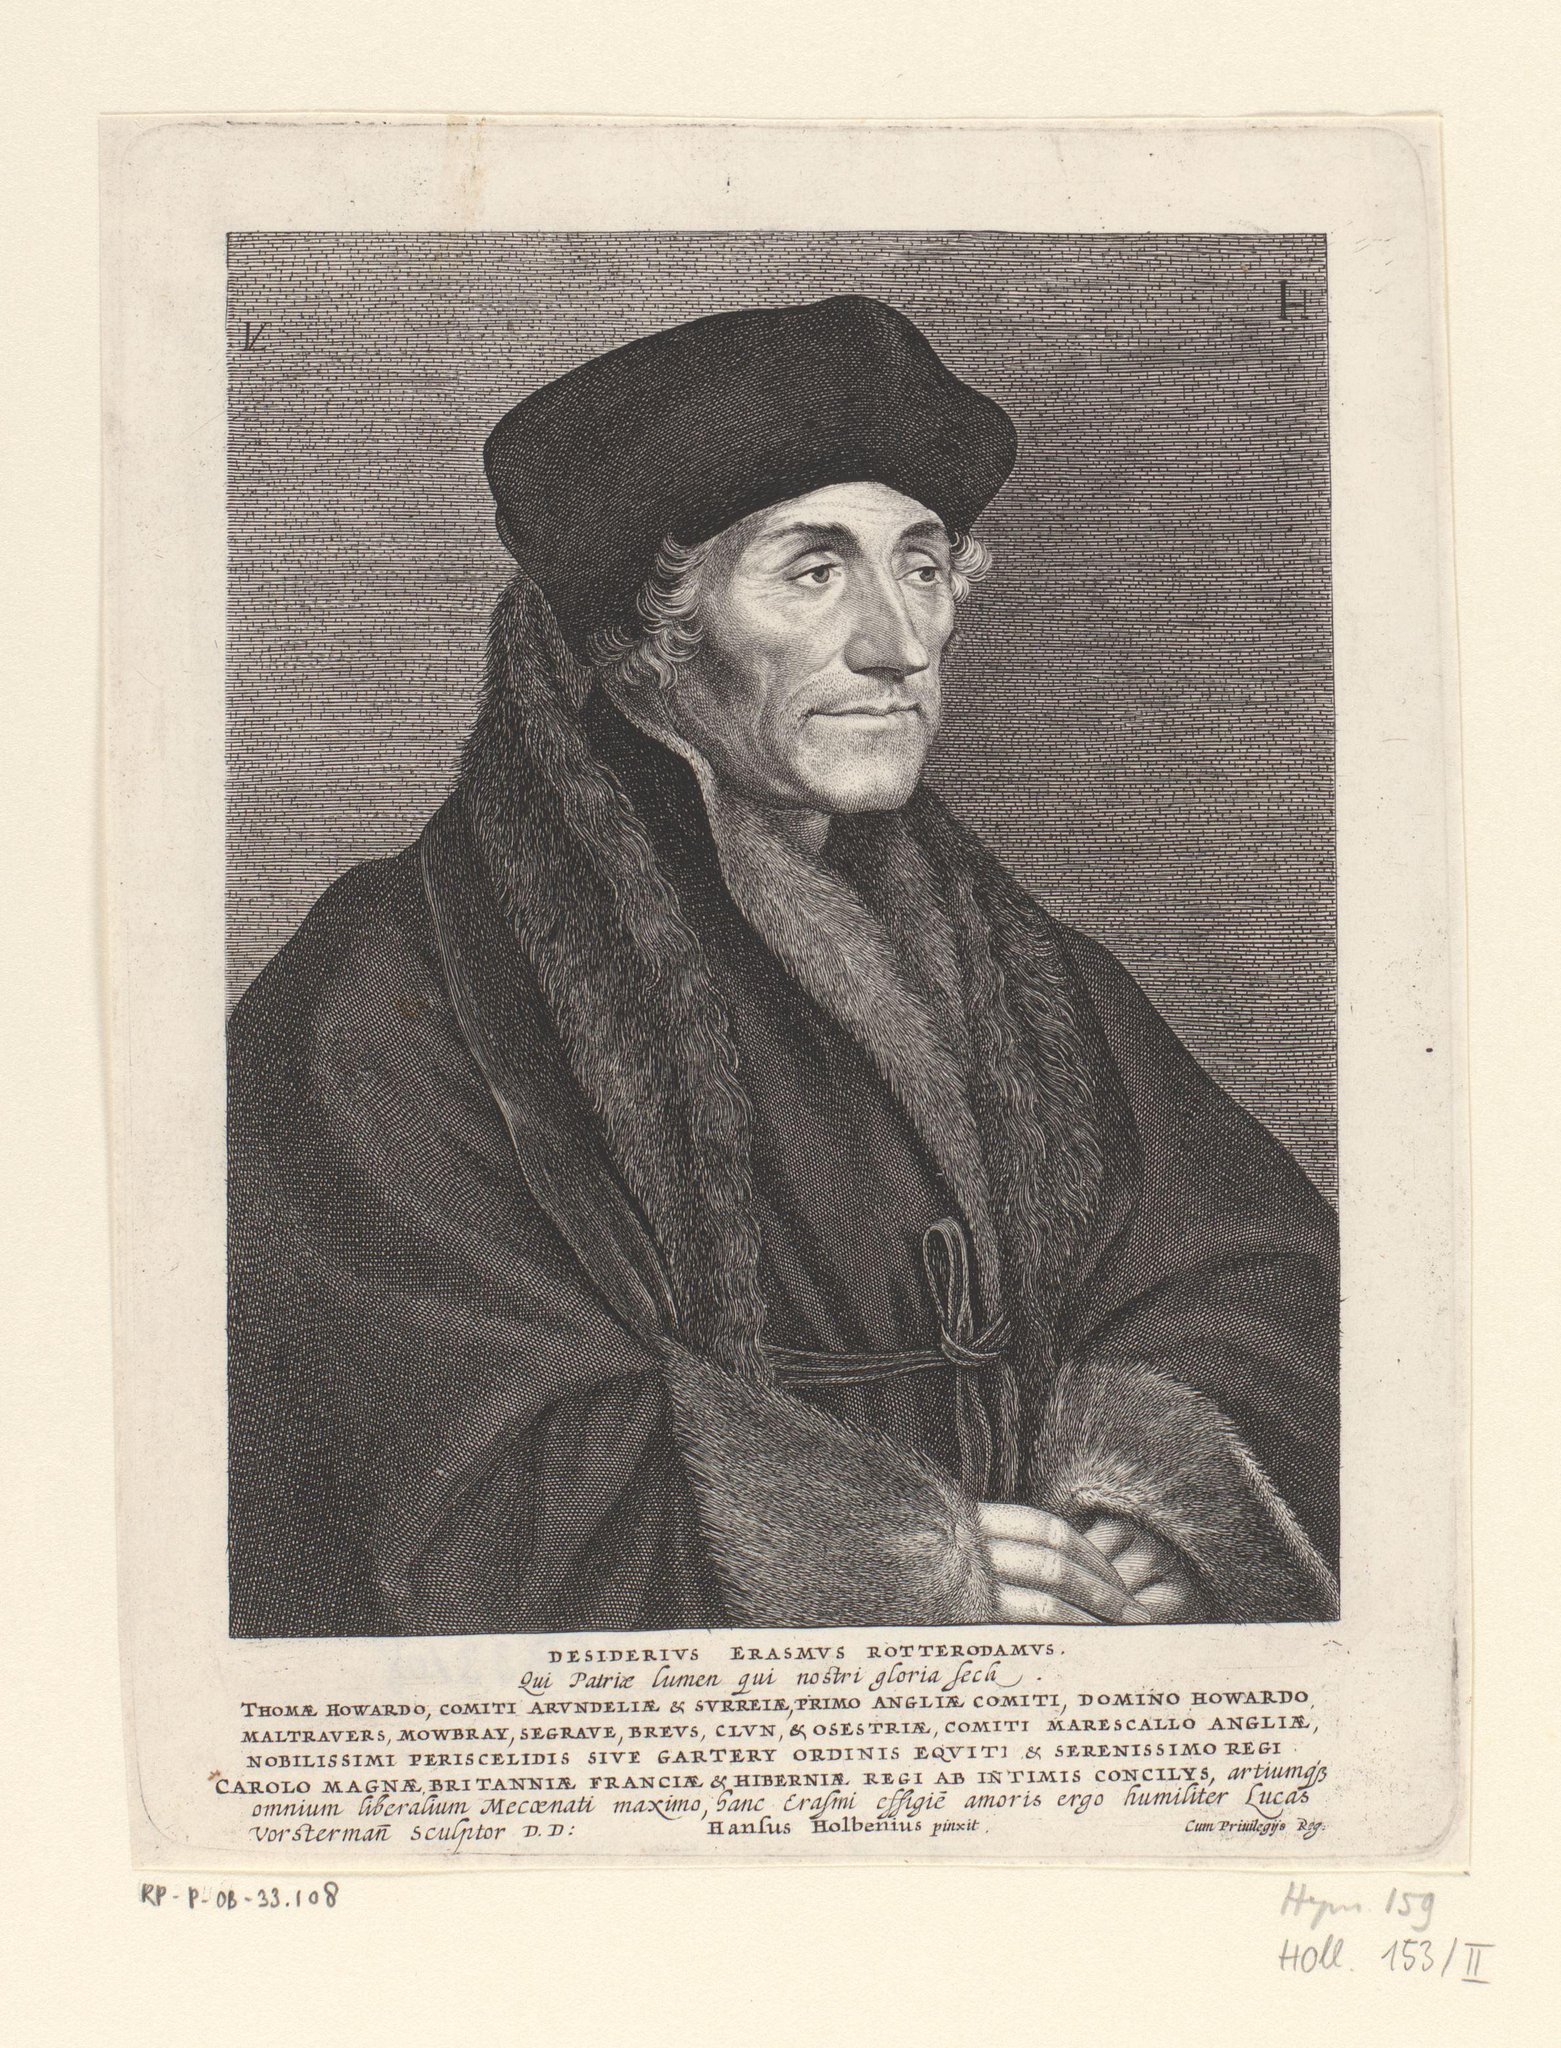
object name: print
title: Portret van Desiderius Erasmus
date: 1625-1630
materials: paper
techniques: engraving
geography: england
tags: rotterdam, desiderius erasmus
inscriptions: collector's mark: Lugt 240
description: Portret van de theoloog Desiderius Erasmus